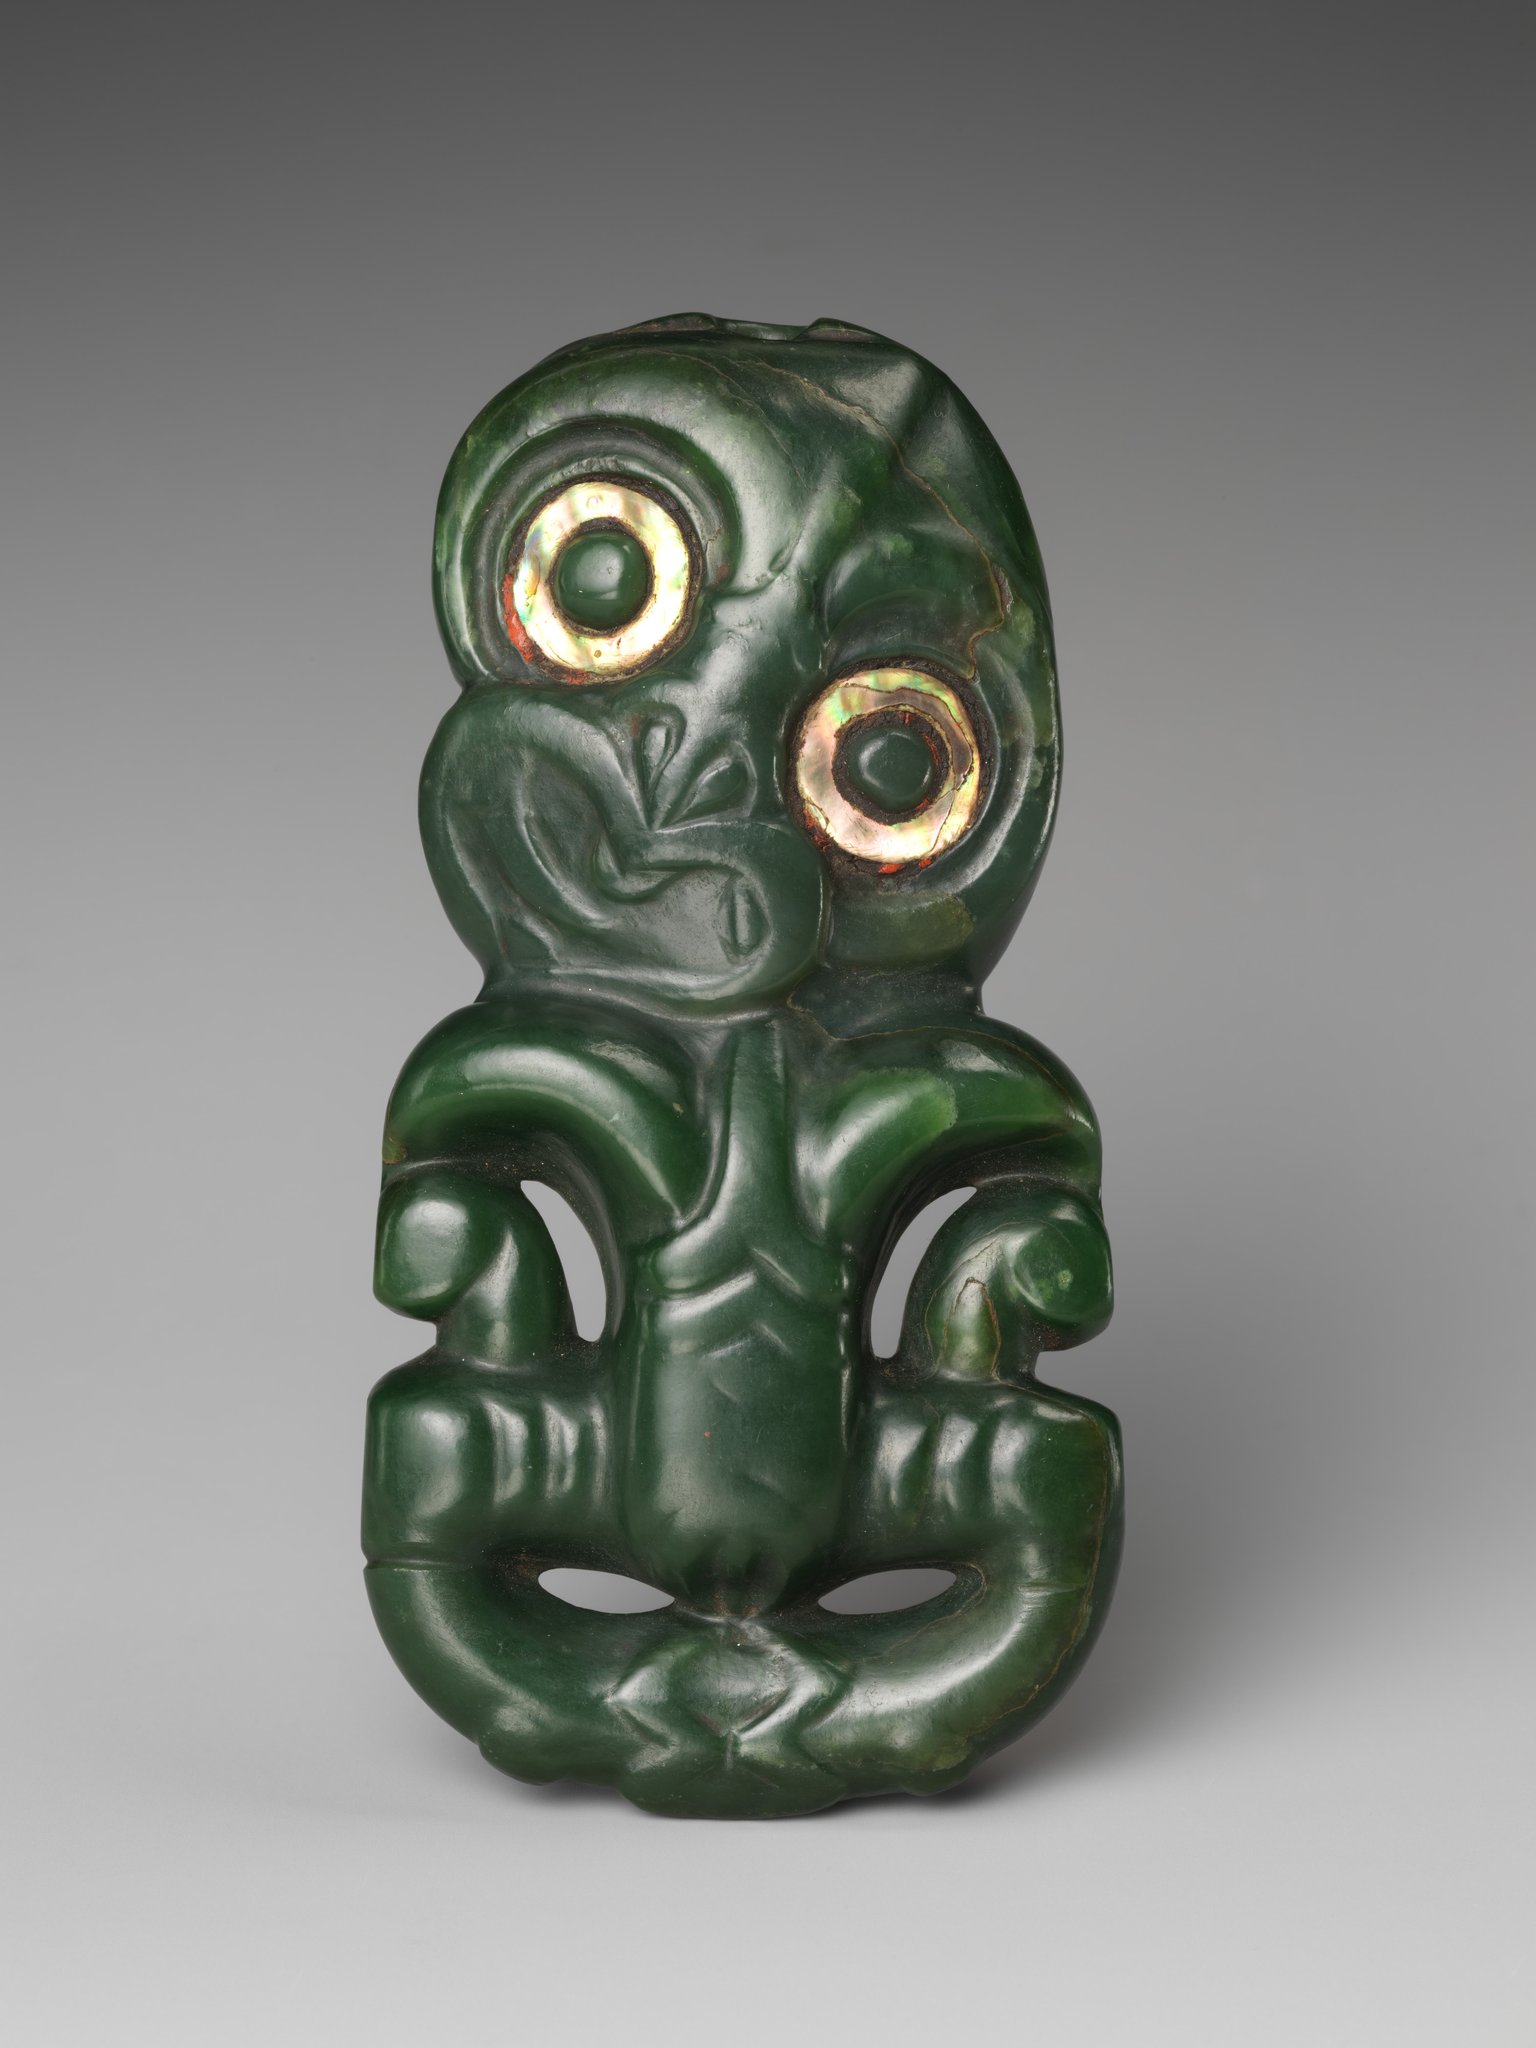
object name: neck ornament hei tiki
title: Greenstone pendant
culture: maori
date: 1801-1900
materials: jade, pigment, shell, wax